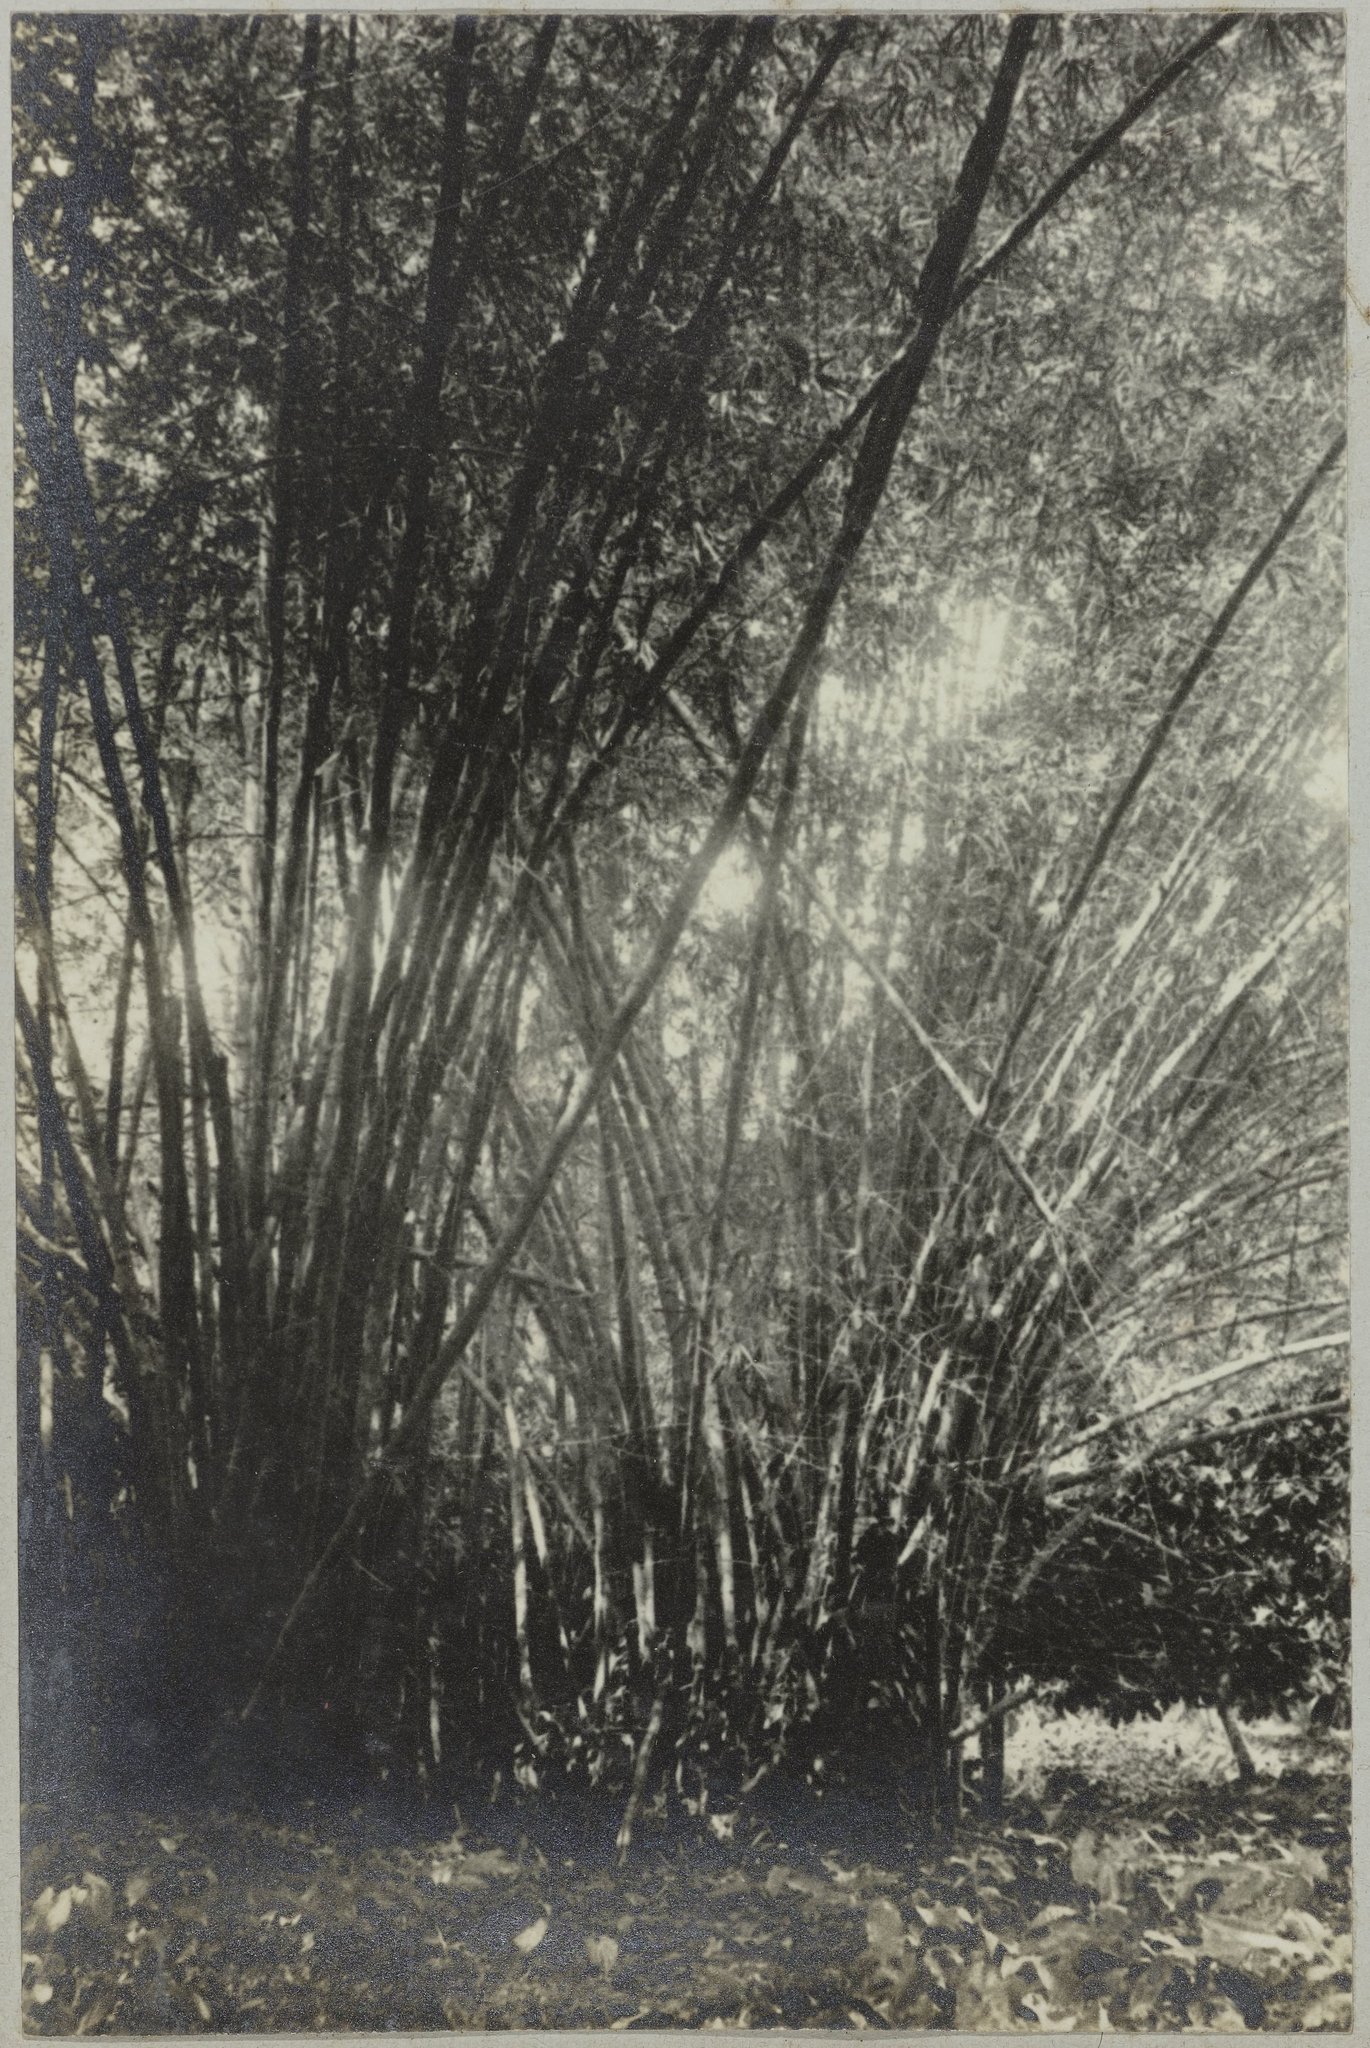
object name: photograph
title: Bamboe op Tourtonne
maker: hendrik doijer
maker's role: engineer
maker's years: 1863-1925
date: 1903-1910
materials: photographic support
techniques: gelatin silver print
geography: suriname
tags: suriname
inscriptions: inscription: ‘A2 / Bamboe op Tourtonne.’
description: Hoge bamboestruiken groeiend op de plantage Tourtonne. Onderdeel van het fotoalbum Souvenir de Voyage (deel 1), over het leven van de familie Doijer in en rond de plantage Ma Retraite in Suriname in de jaren 1903-1910.